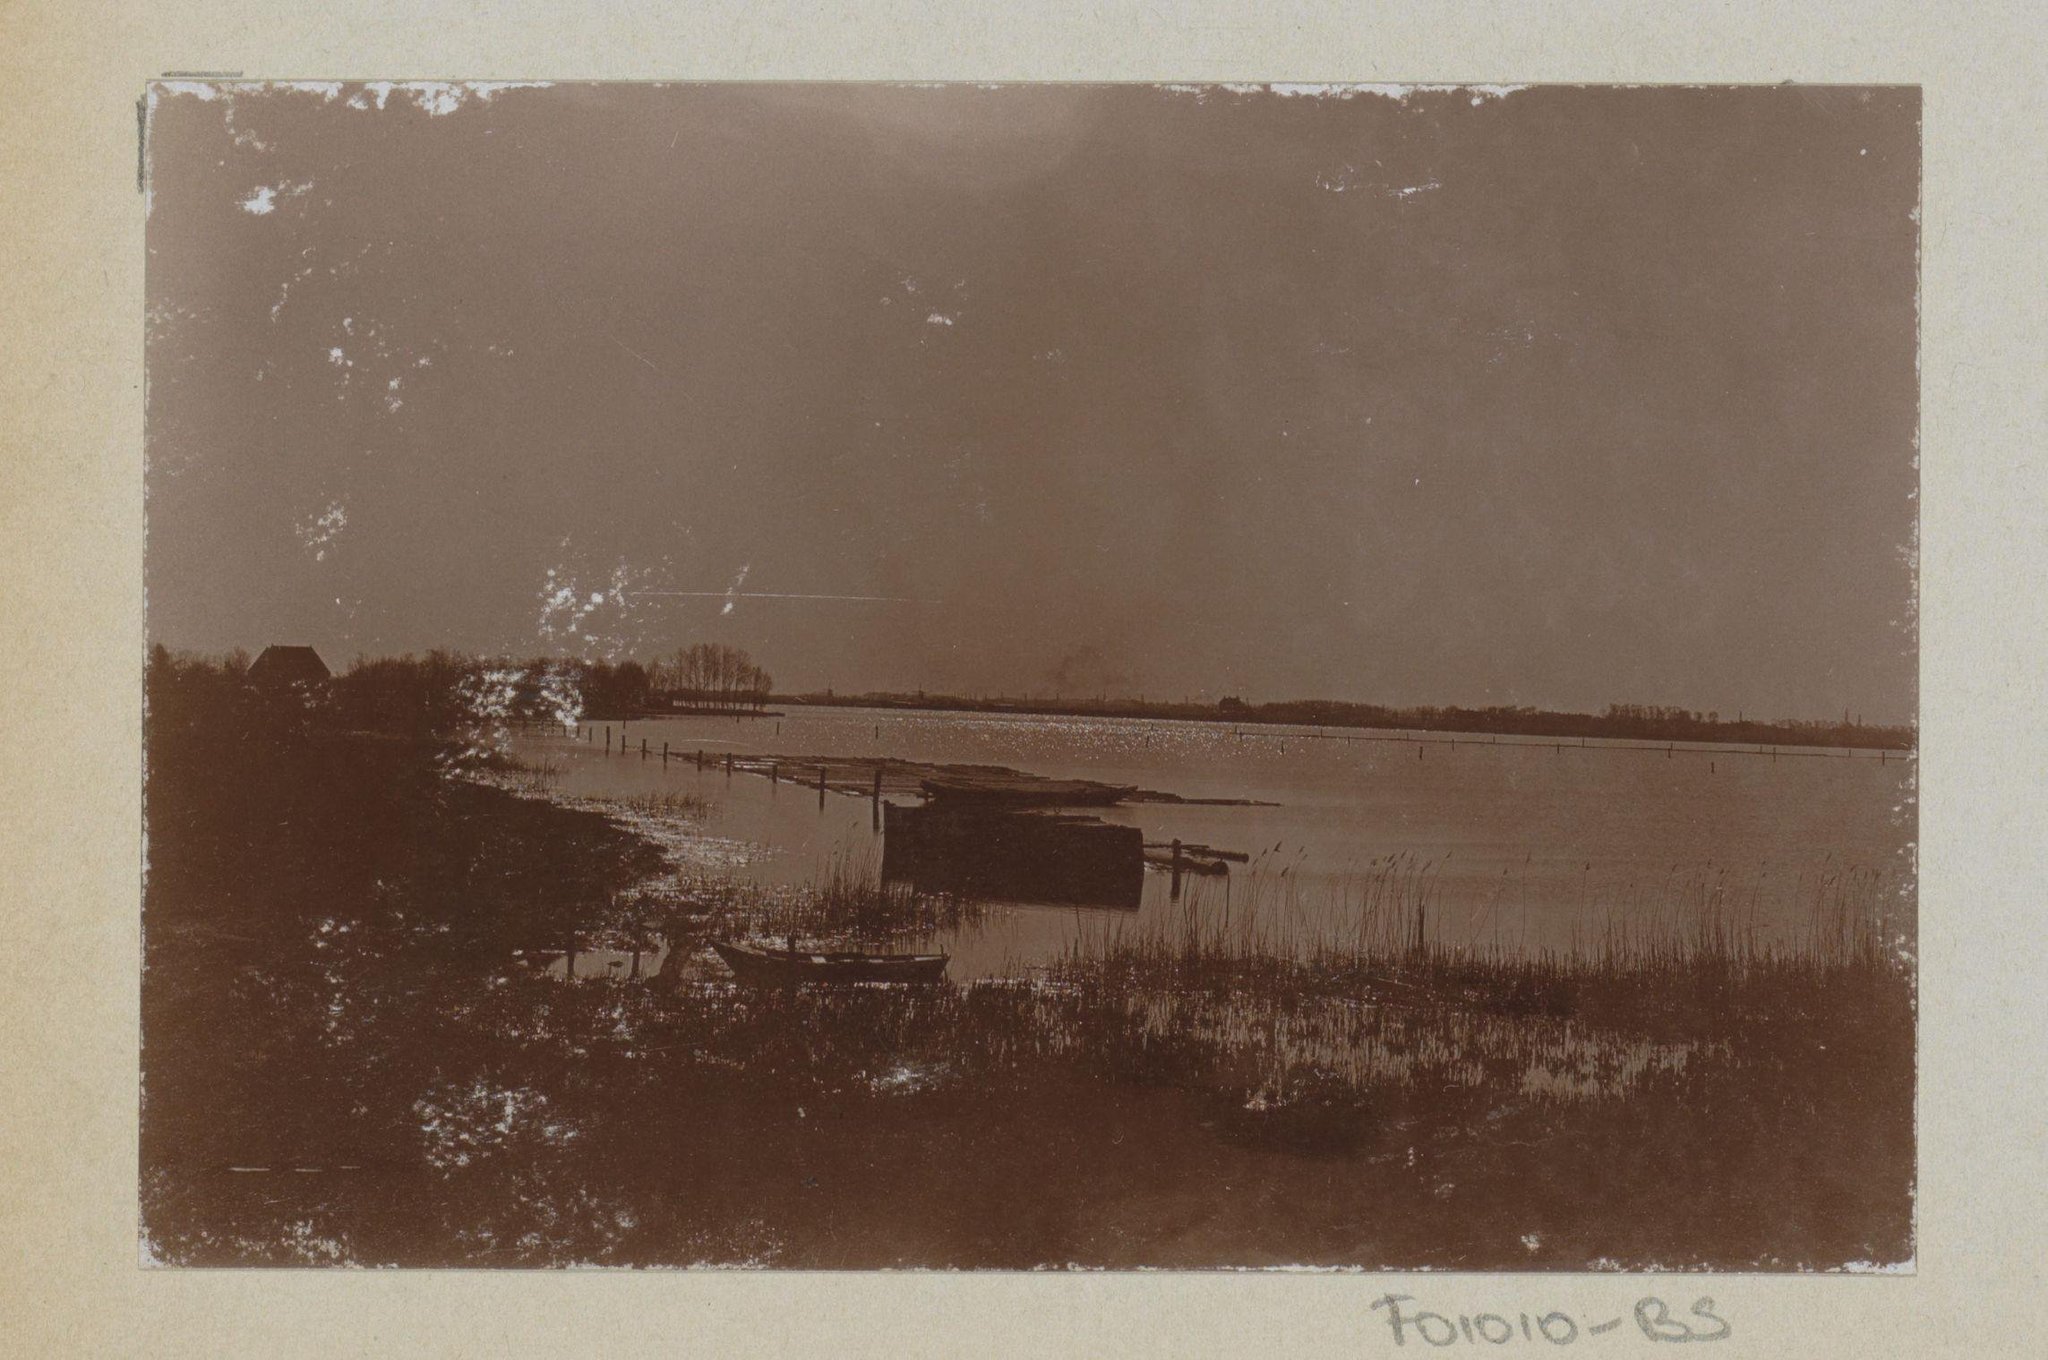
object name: photograph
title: Water bij avond met een bootje aan de wal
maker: Anonymous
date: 1900-1910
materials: photographic support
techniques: collodion silver print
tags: evening, landscapes with waters, waterscapes, seascapes (in the temperate zone), rowing-boat, canoe, etc.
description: Onderdeel van Familiealbum met onder meer foto's van Wijnhandel Kraaij & Co. Bordeaux-Amsterdam.